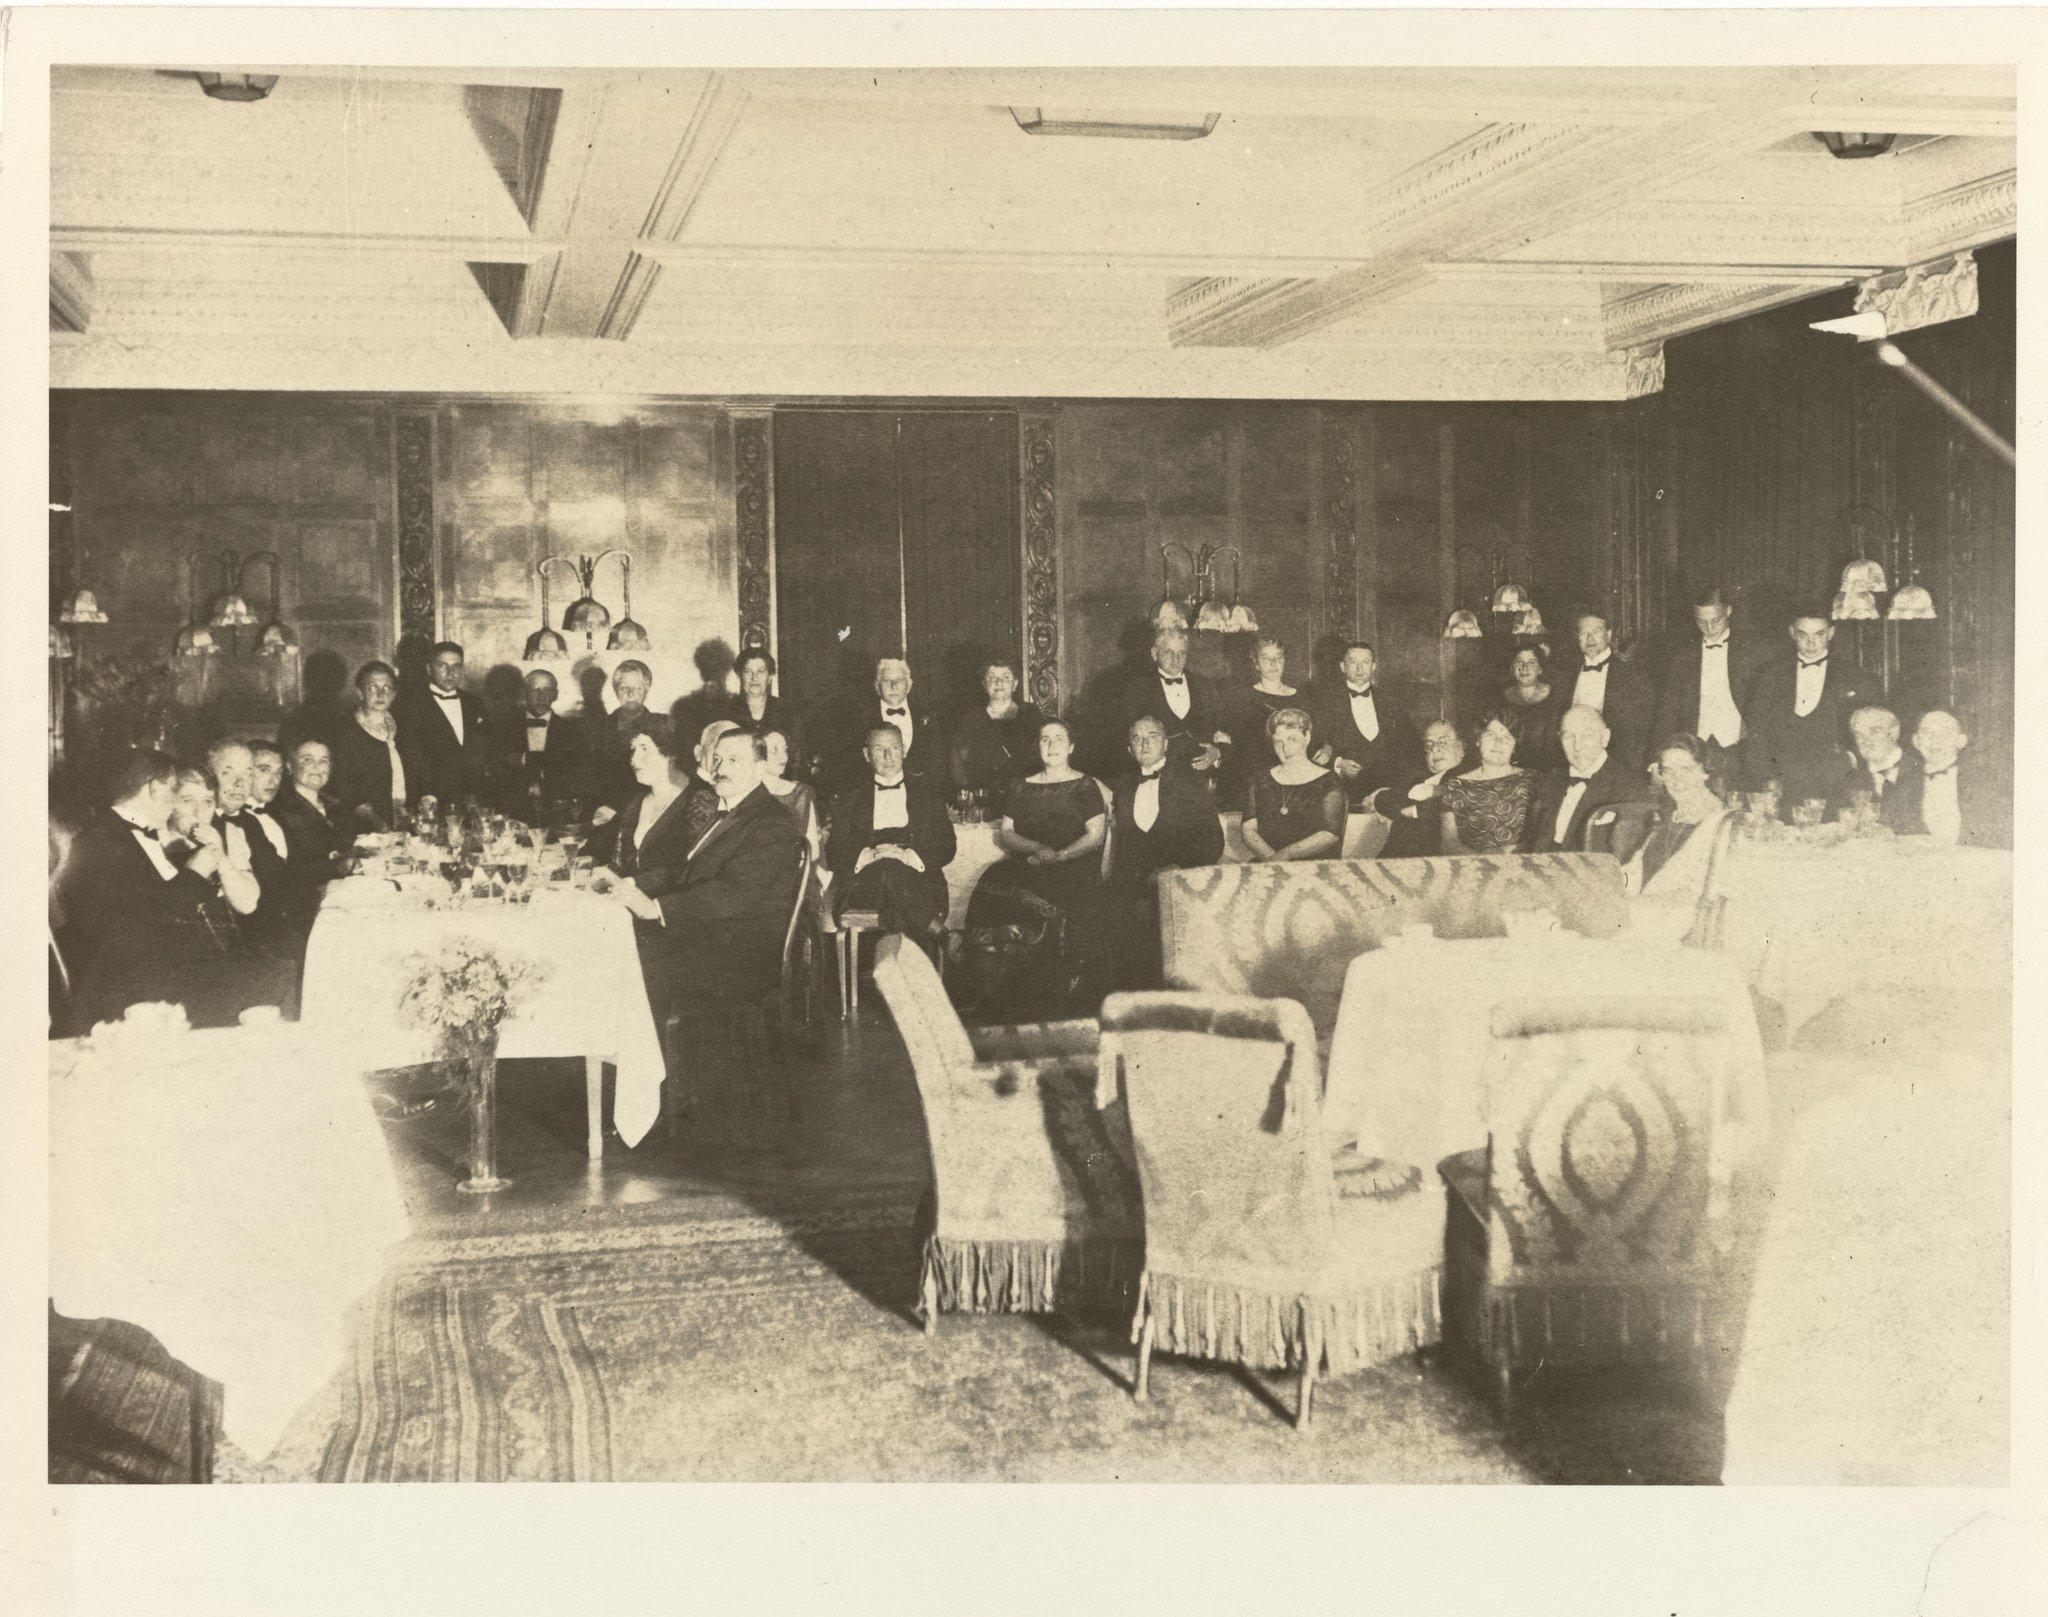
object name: photograph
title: Eugen Wachenheimer en zijn echtgenote Else Wachenheimer-Moos in avondkleding in een zaal met onbekende personen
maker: Anonymous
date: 1922-1937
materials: photographic support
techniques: gelatin silver print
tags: eugen wachenheimer, else wachenheimer-moos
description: Eugen Wachenheimer (gezeten op een bank, achtste van rechts) en zijn echtgenote Else Wachenheimer-Moos (gezeten op een bank, negende van rechts) in avondkleding in een zaal met onbekende personen.